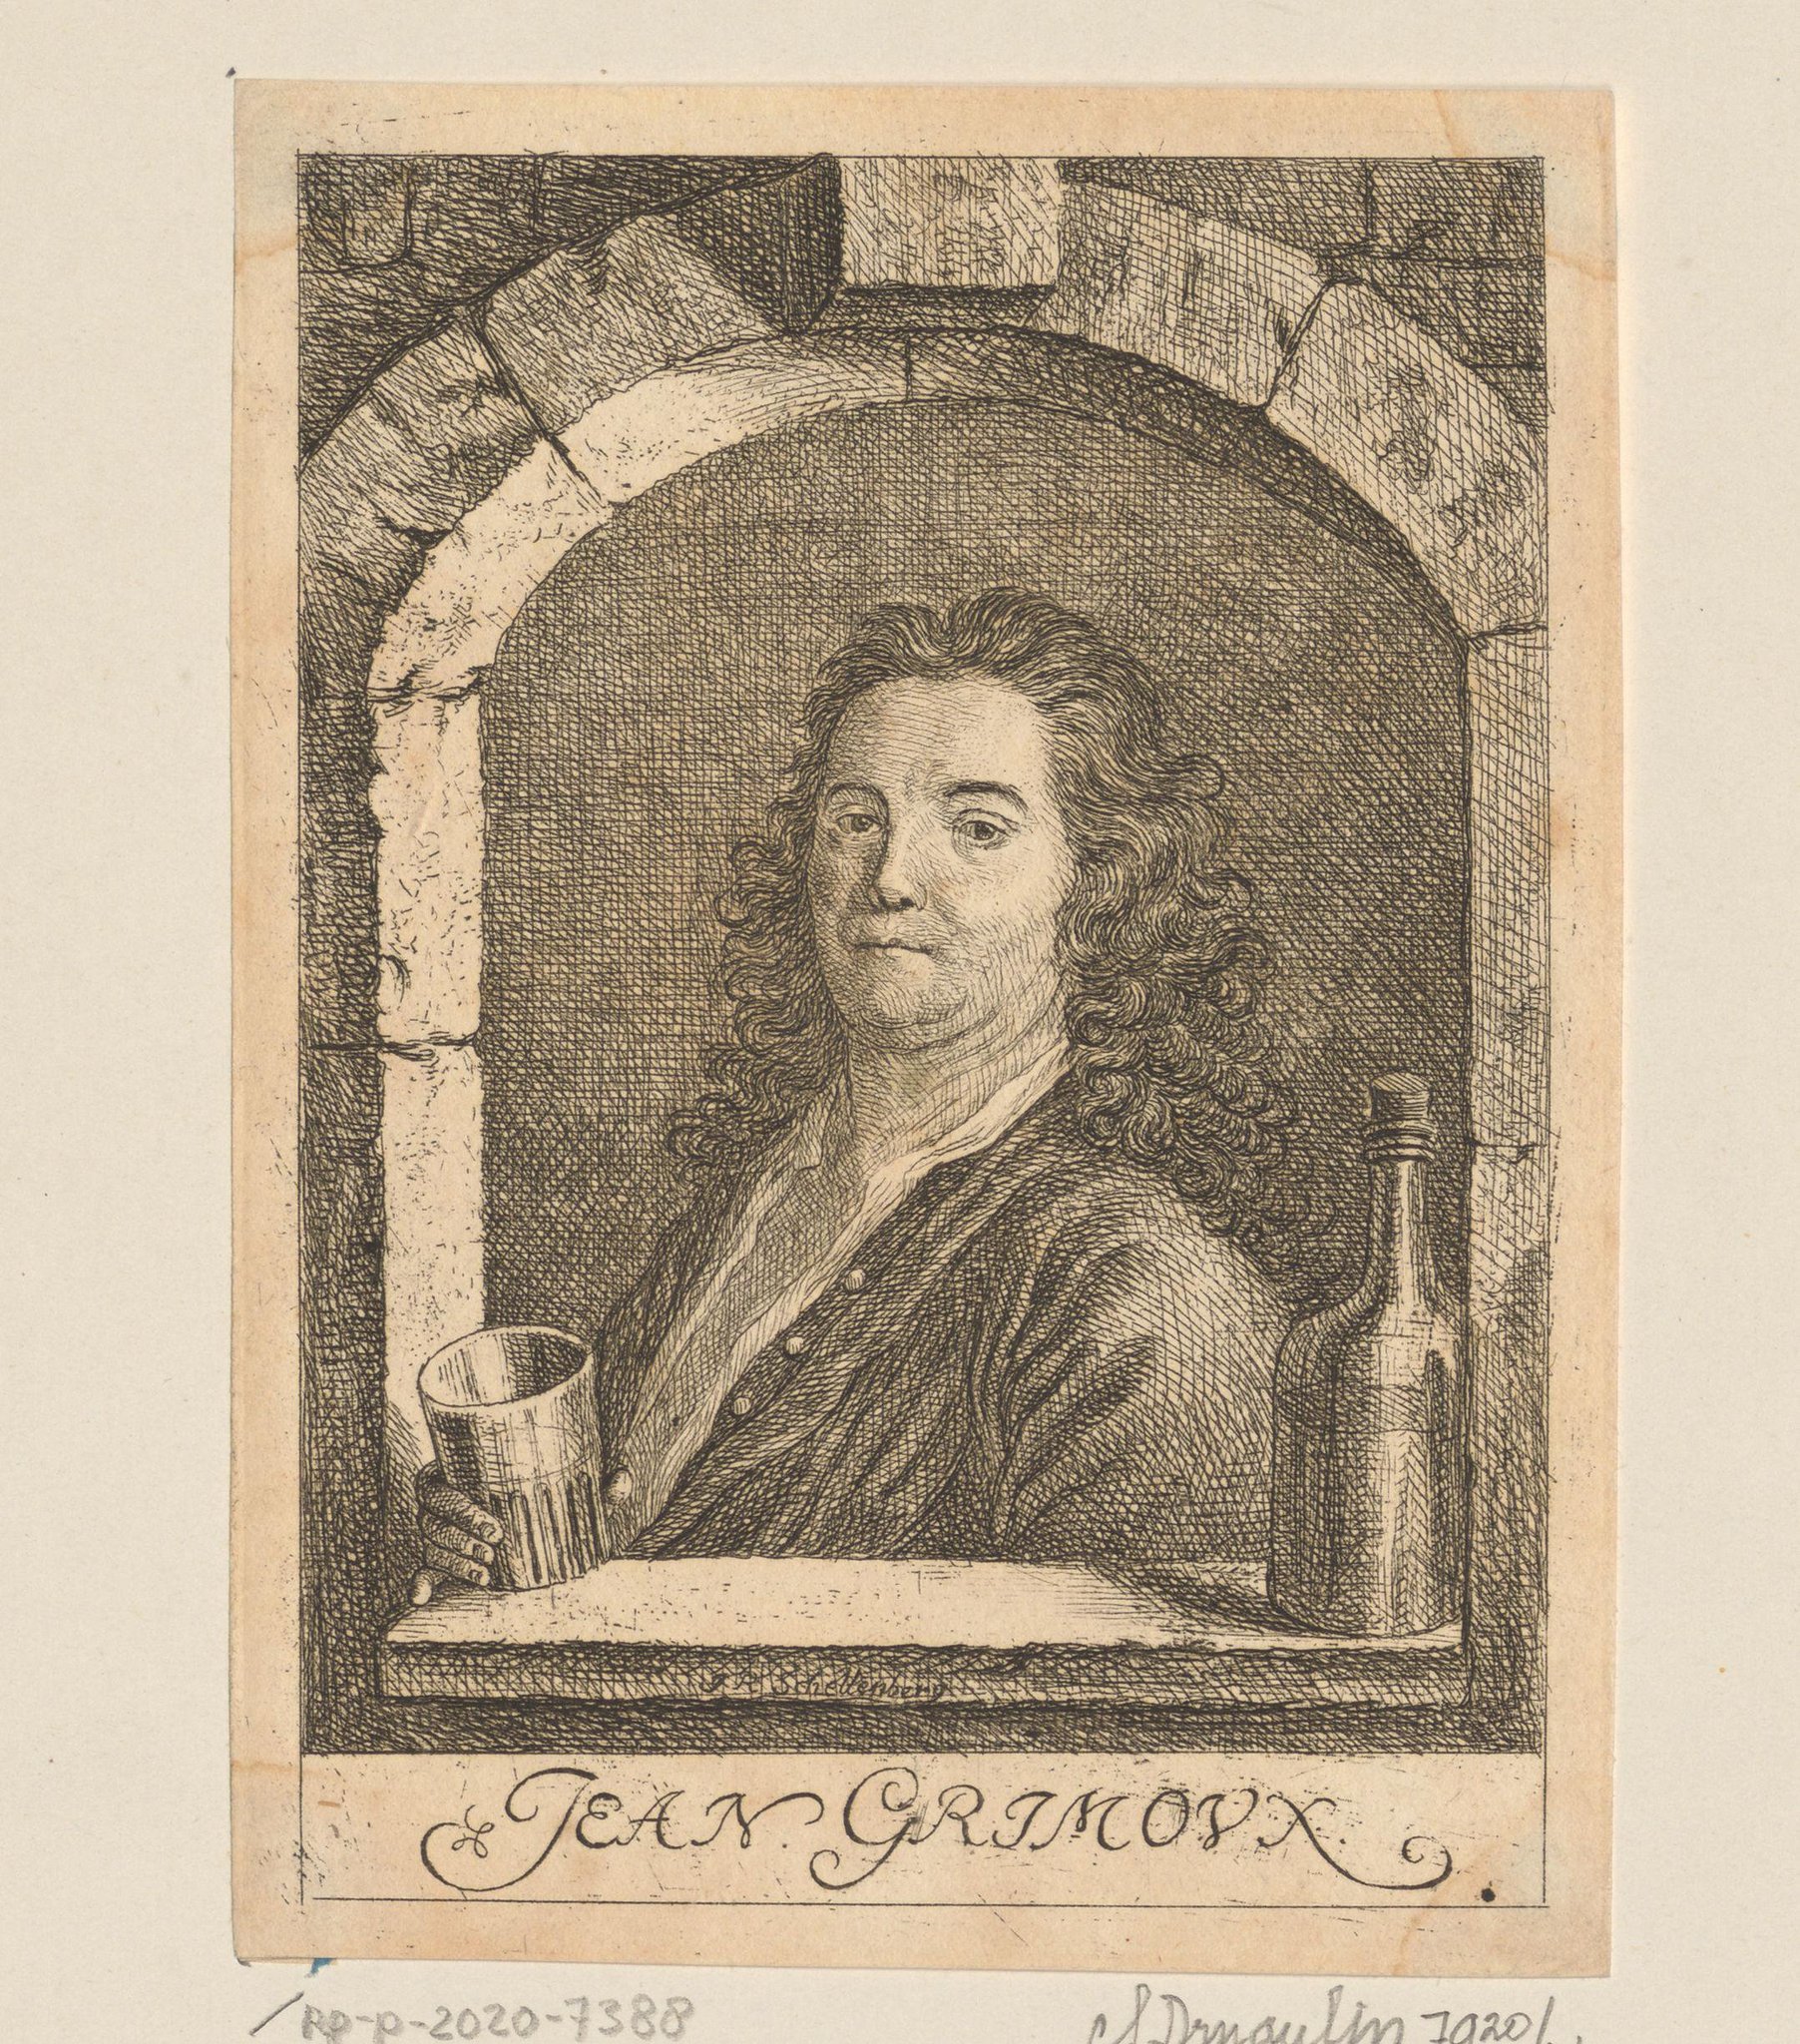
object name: print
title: Portret van Jean Grimoux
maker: Anonymous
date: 1640-1740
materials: paper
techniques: engraving, etching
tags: painter, artist, jean grimoux, historical persons, portrait, self-portrait of graphic artist